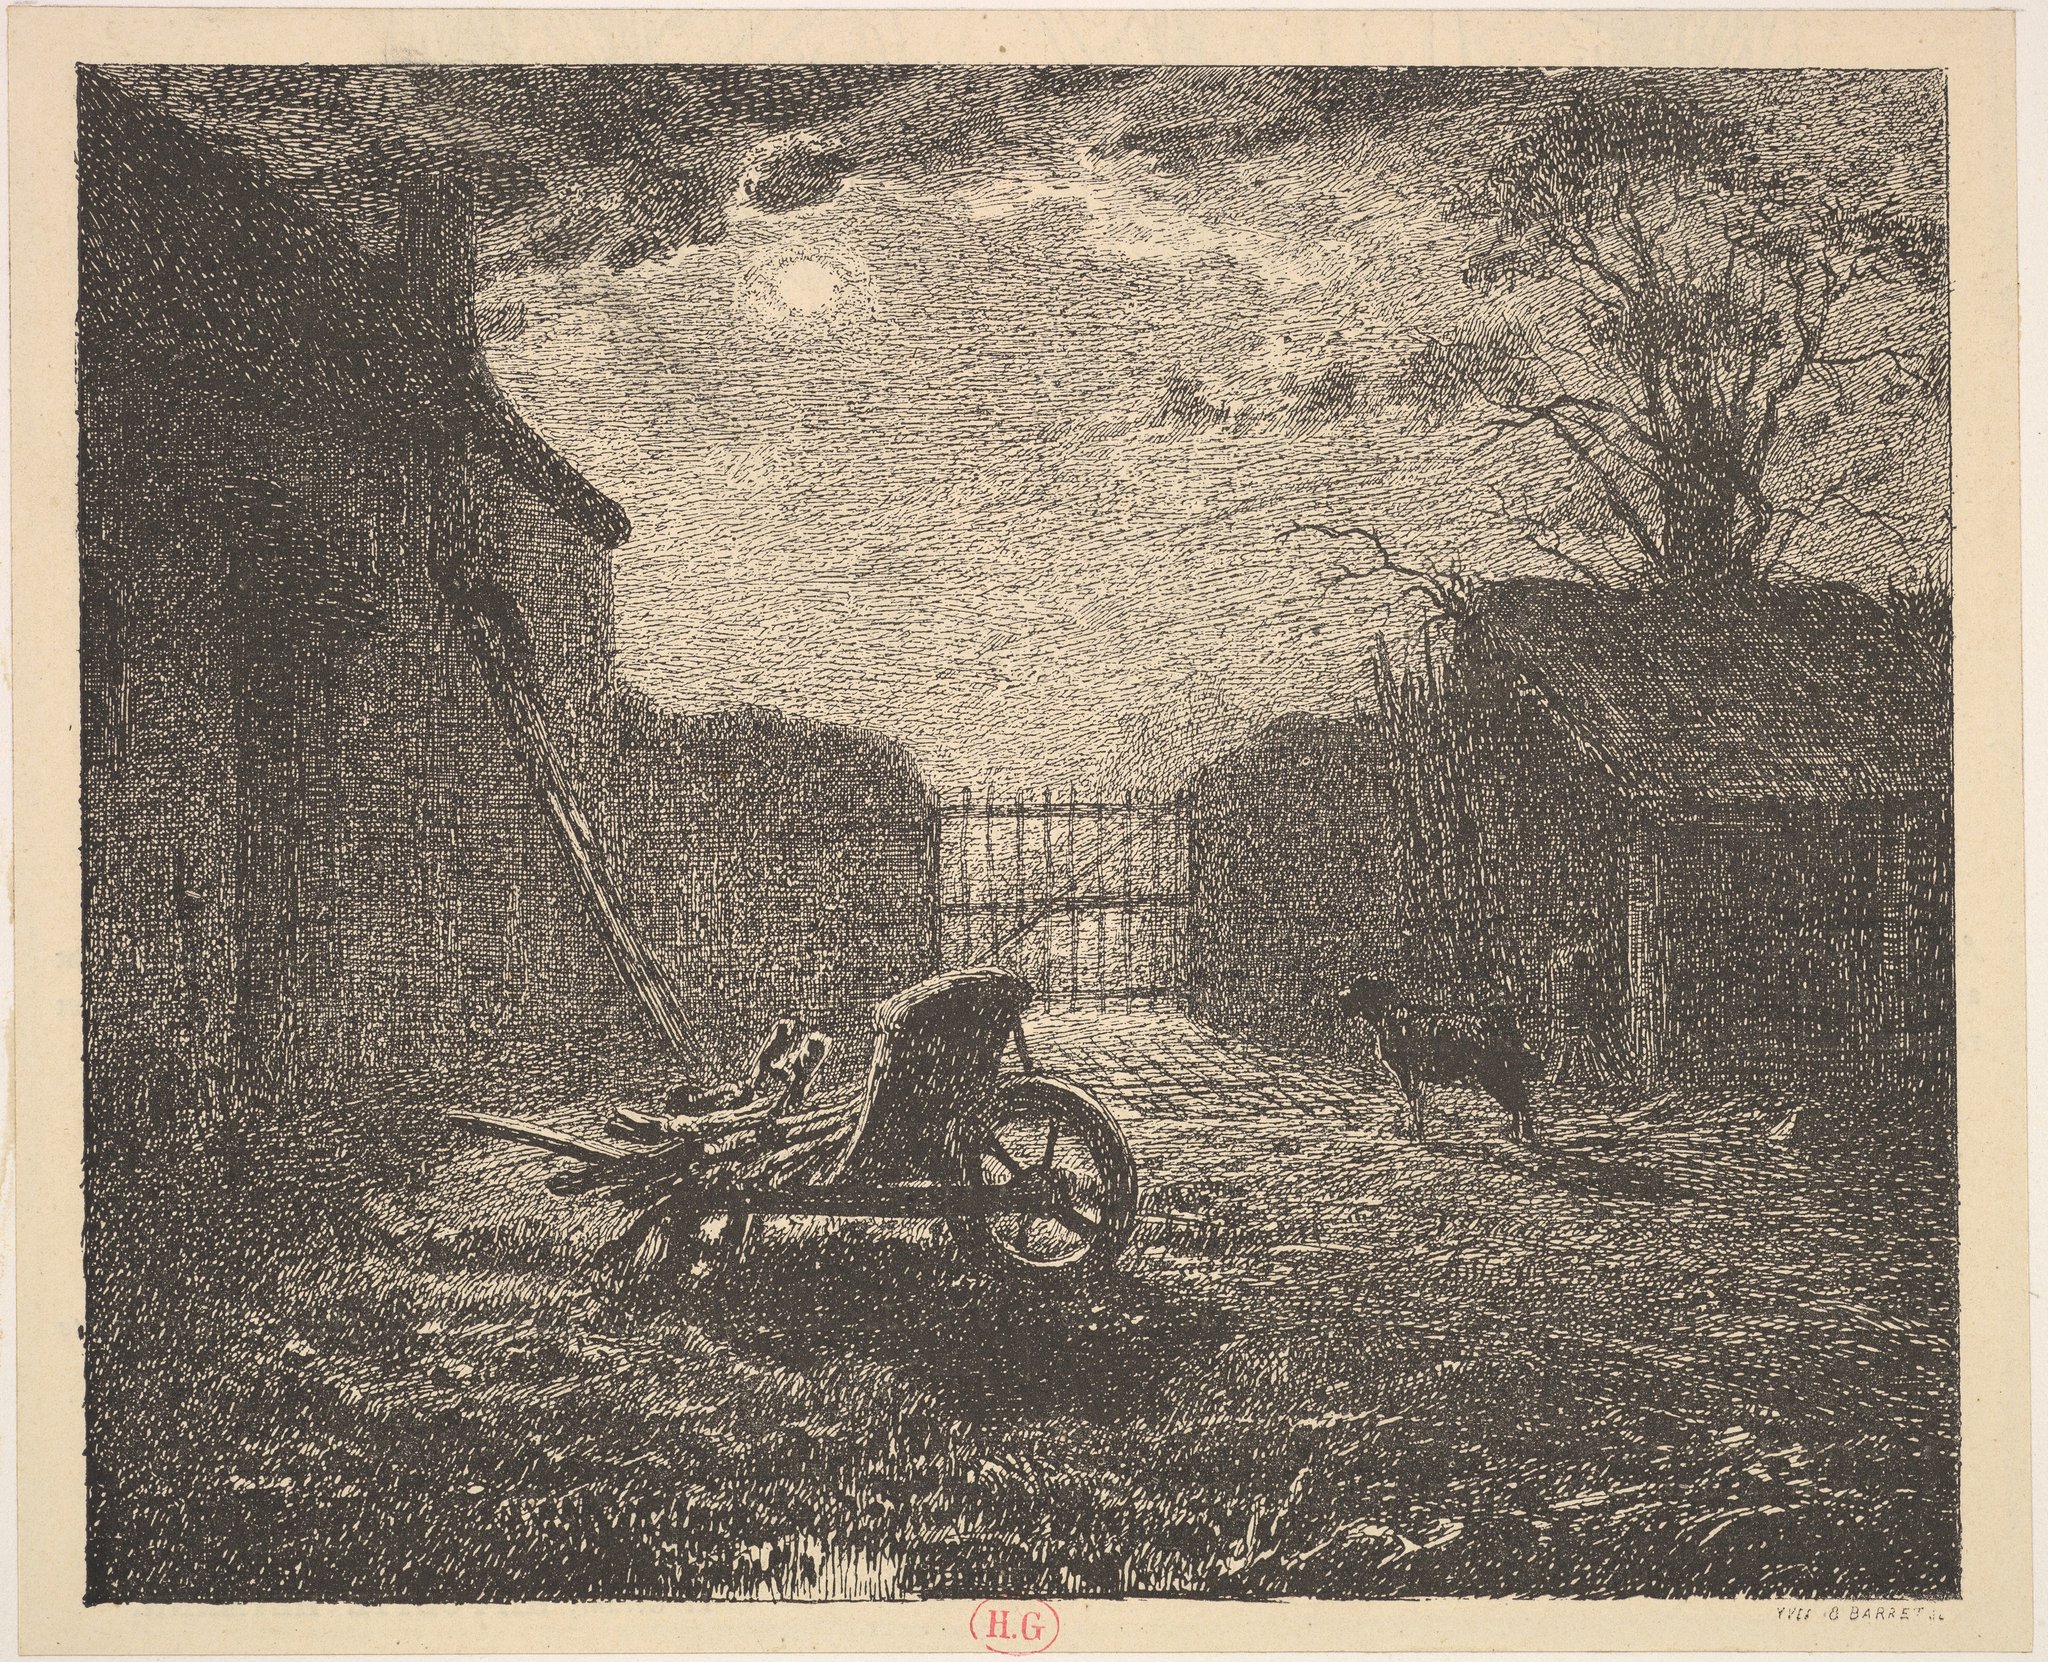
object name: print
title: Moonlight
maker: jean-françois millet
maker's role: artist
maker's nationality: french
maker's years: 1814-1875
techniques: woodcut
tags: barns,dogs,moon,night